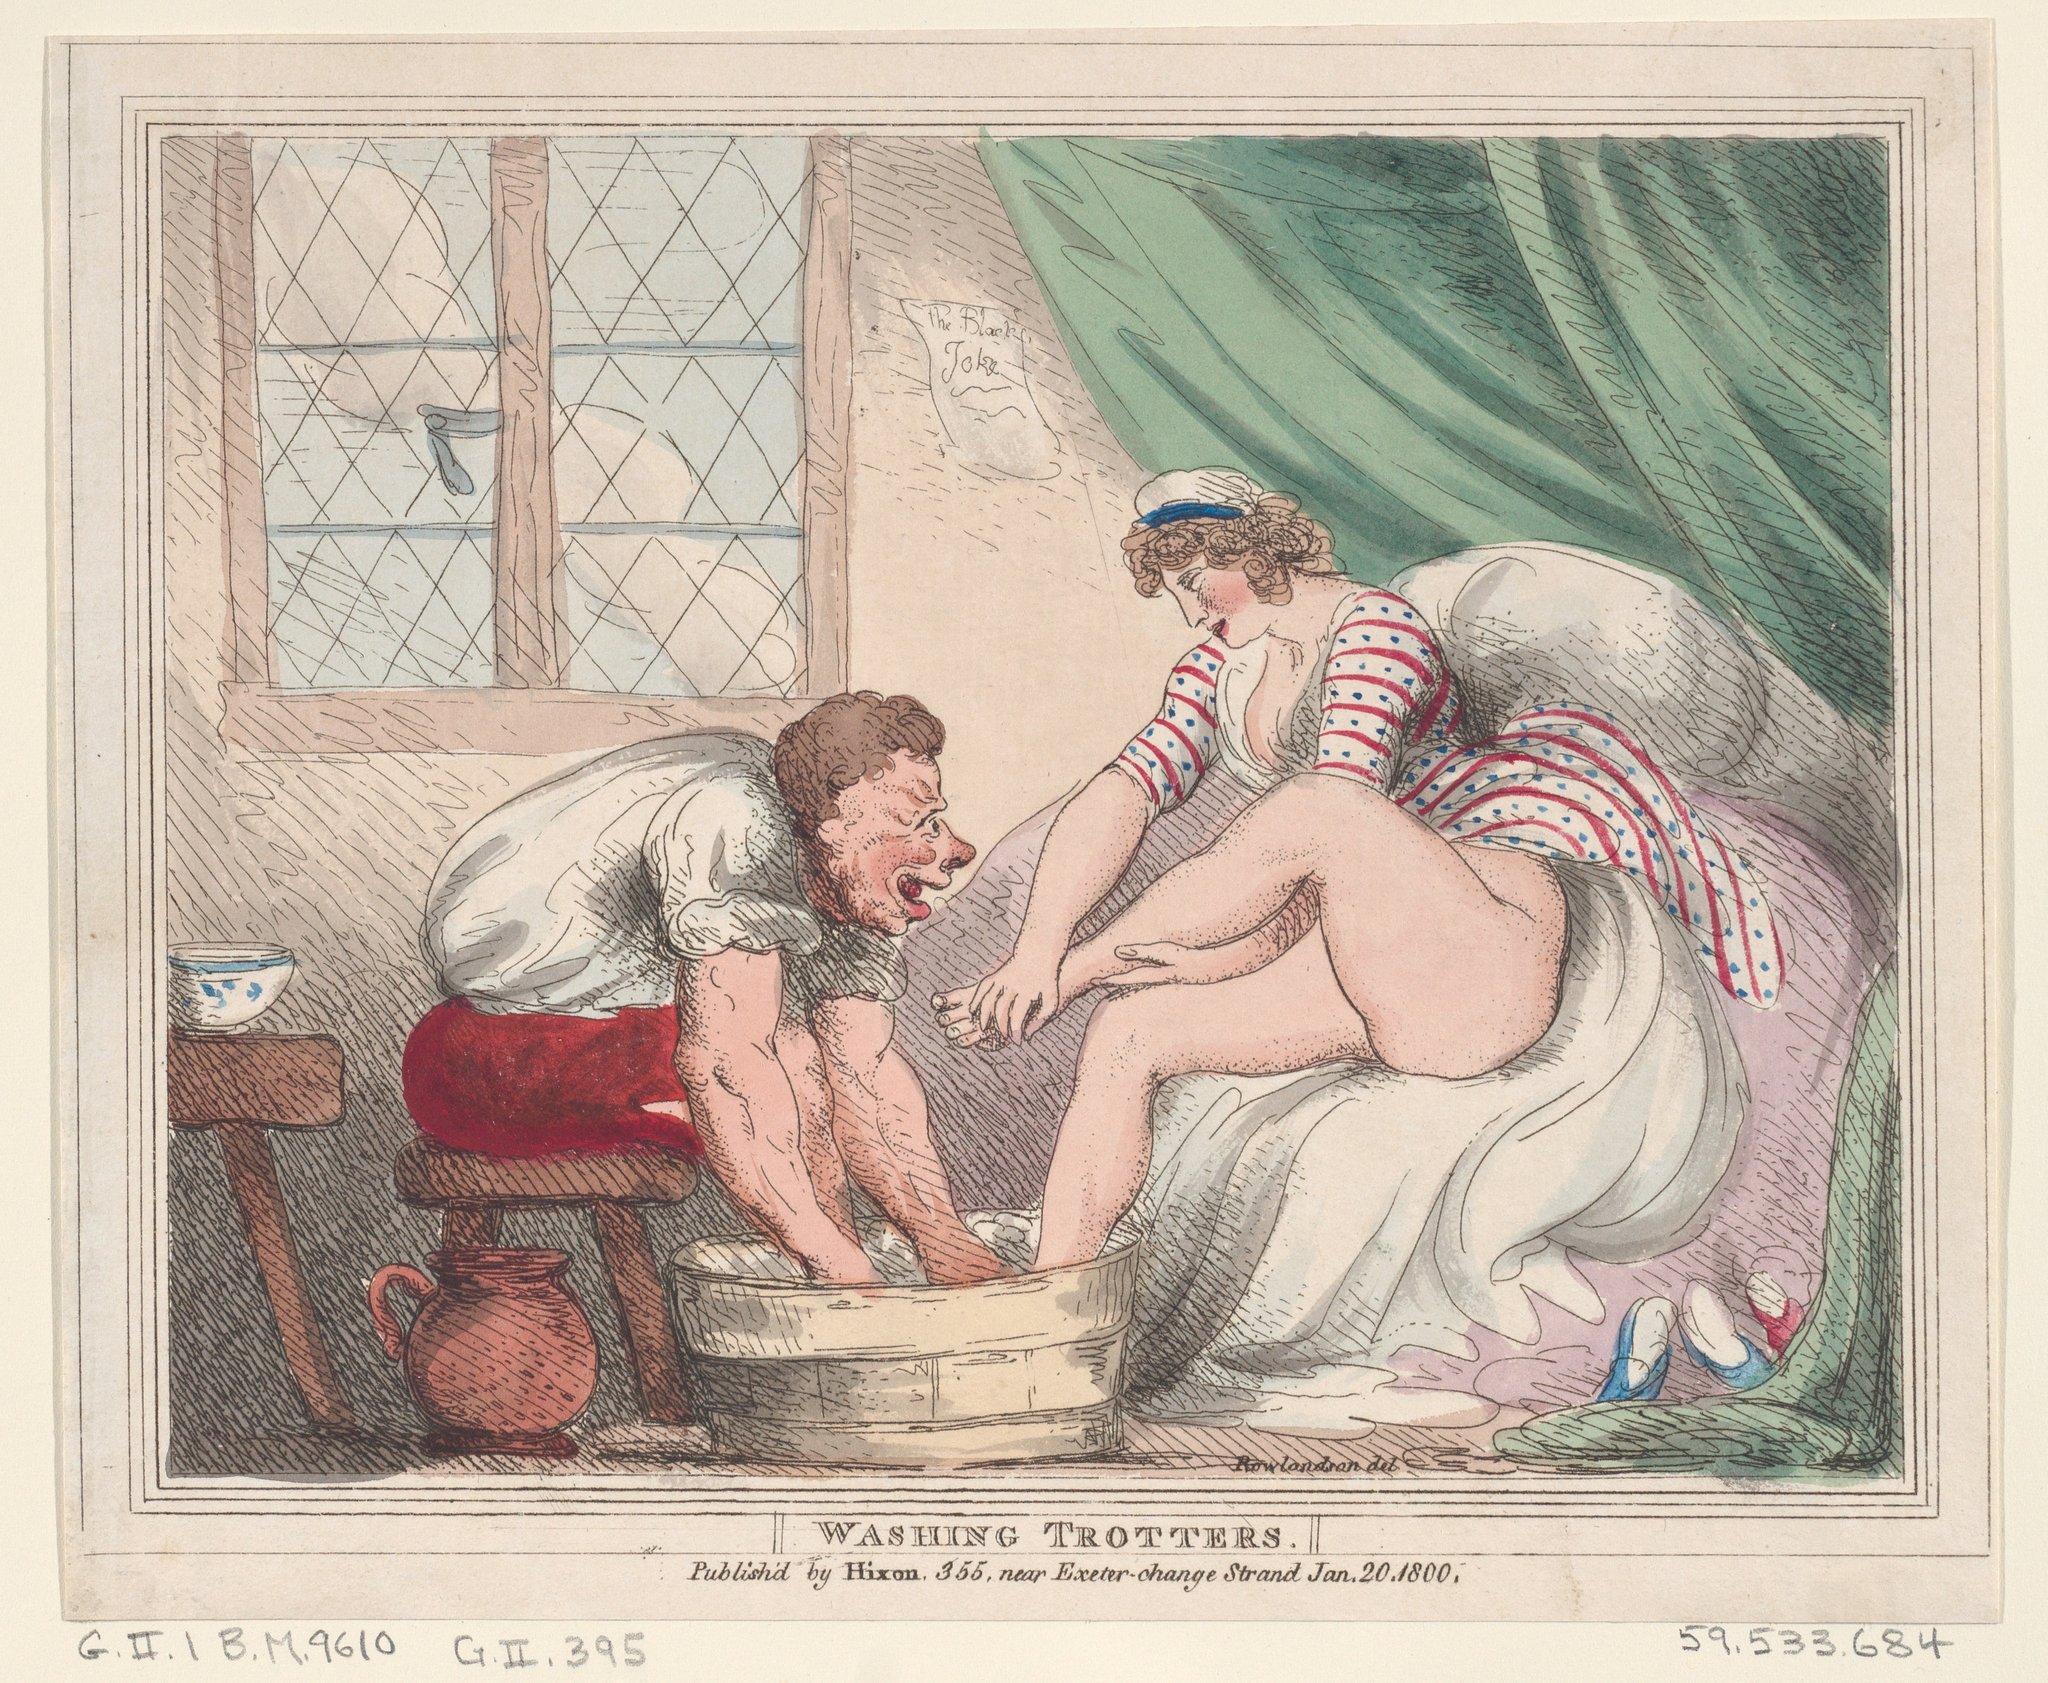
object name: print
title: Washing Trotters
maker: thomas rowlandson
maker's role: artist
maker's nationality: british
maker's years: 1757-1827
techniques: etching, hand coloring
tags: men